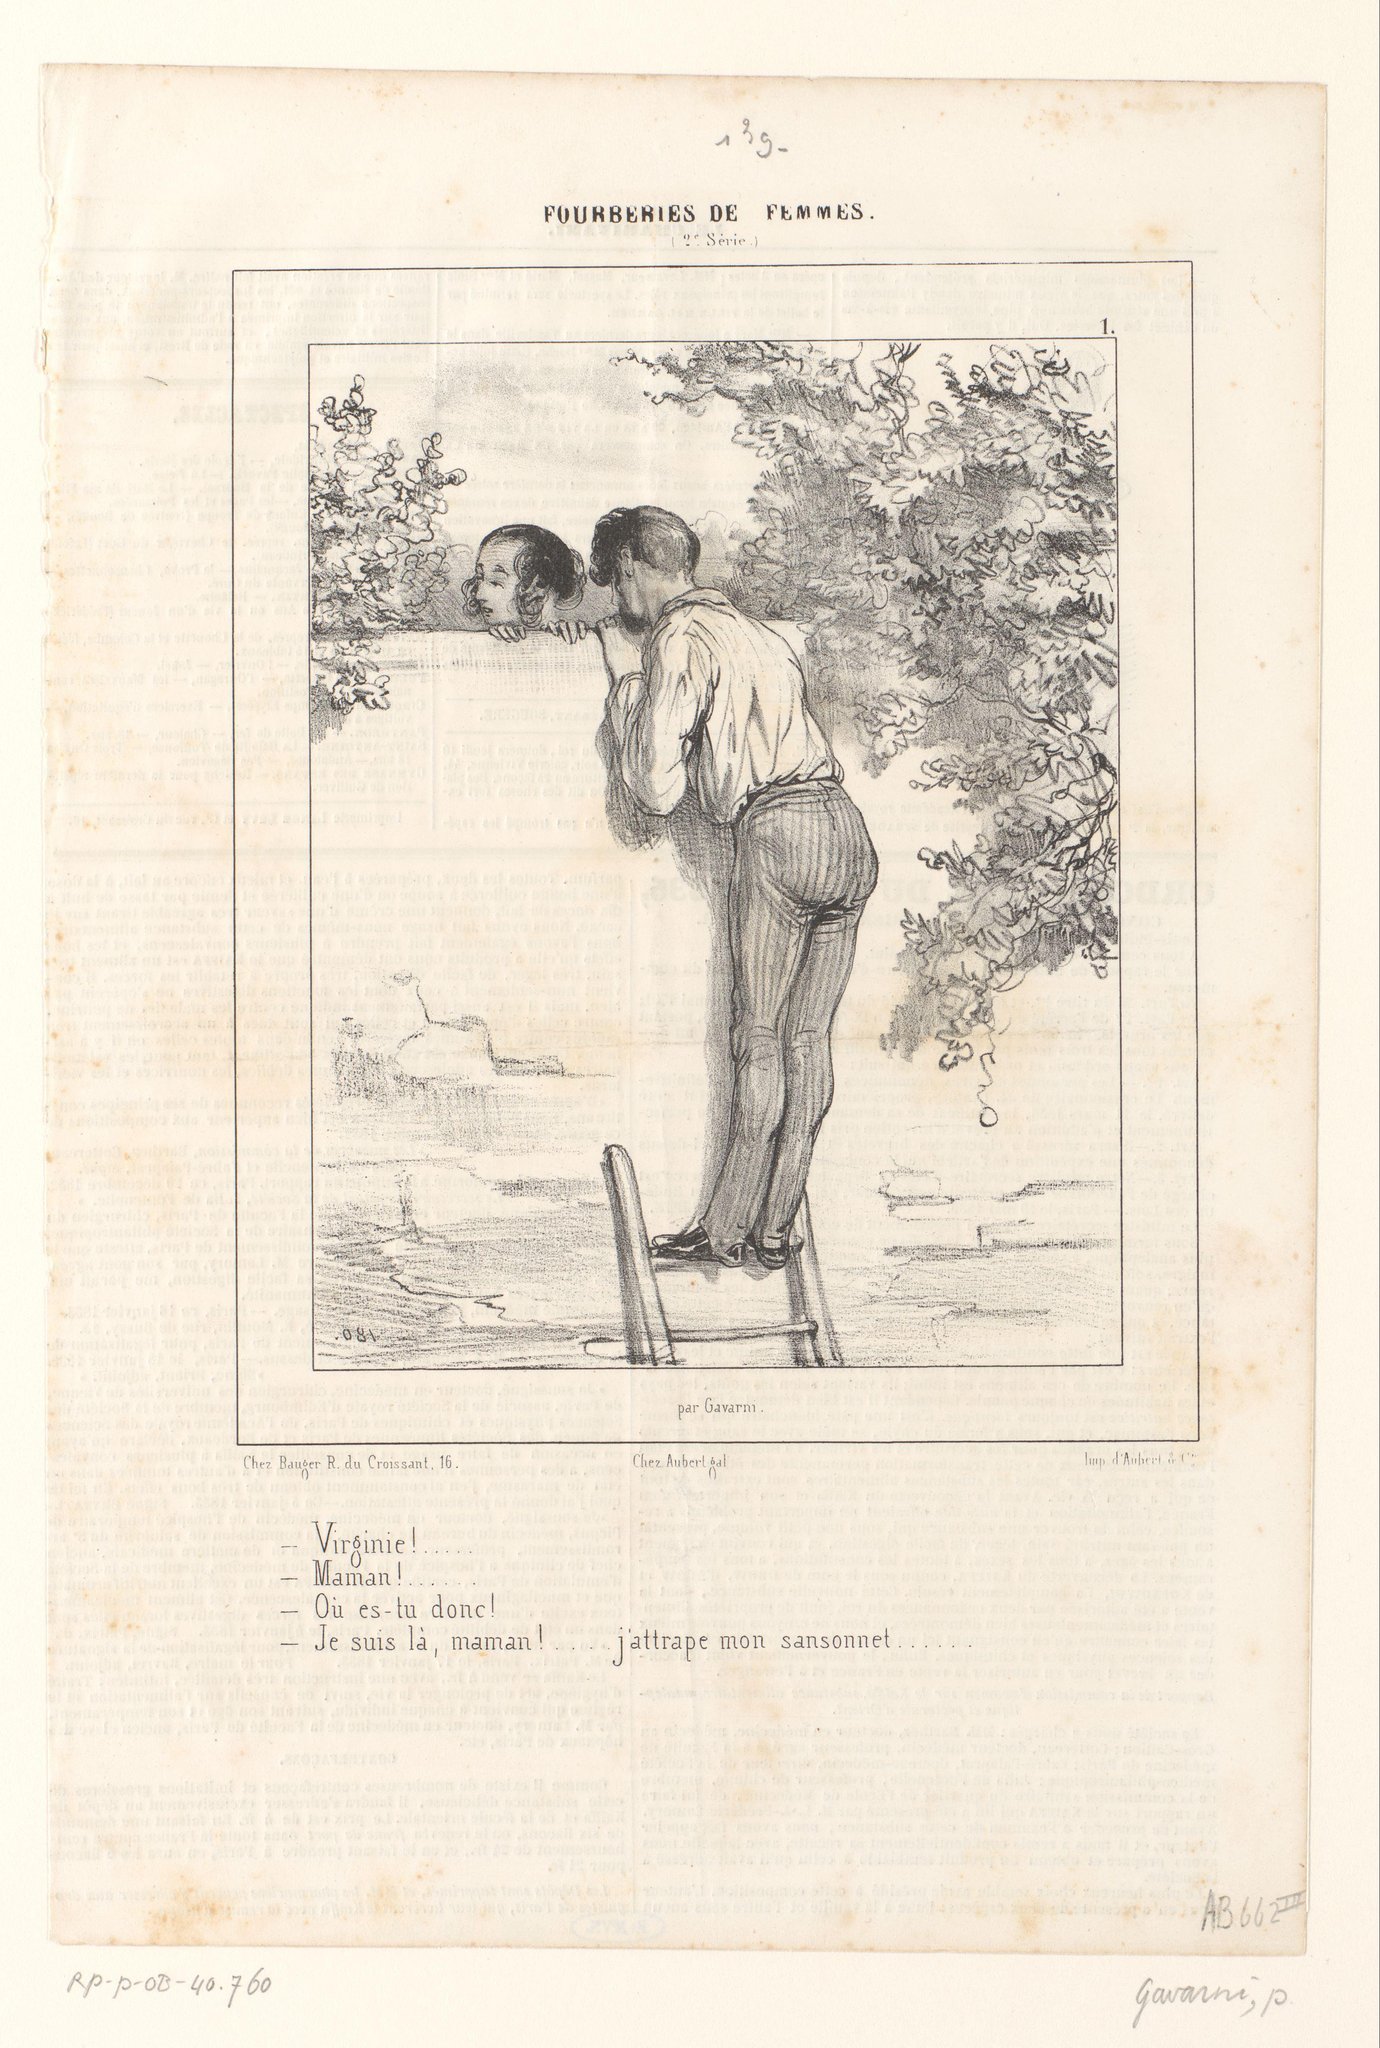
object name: cartoon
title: Fourberies de femmes en matière de sentiment (2)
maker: paul gavarni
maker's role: draughtsman, print maker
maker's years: 1804-1866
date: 1840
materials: paper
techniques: lithograph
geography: paris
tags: fence, wall, paling, lovers' meeting, hidden love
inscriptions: collector's mark: Lugt 2228a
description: Prent gebruikt voor: Le Charivari, 9 september 1840.